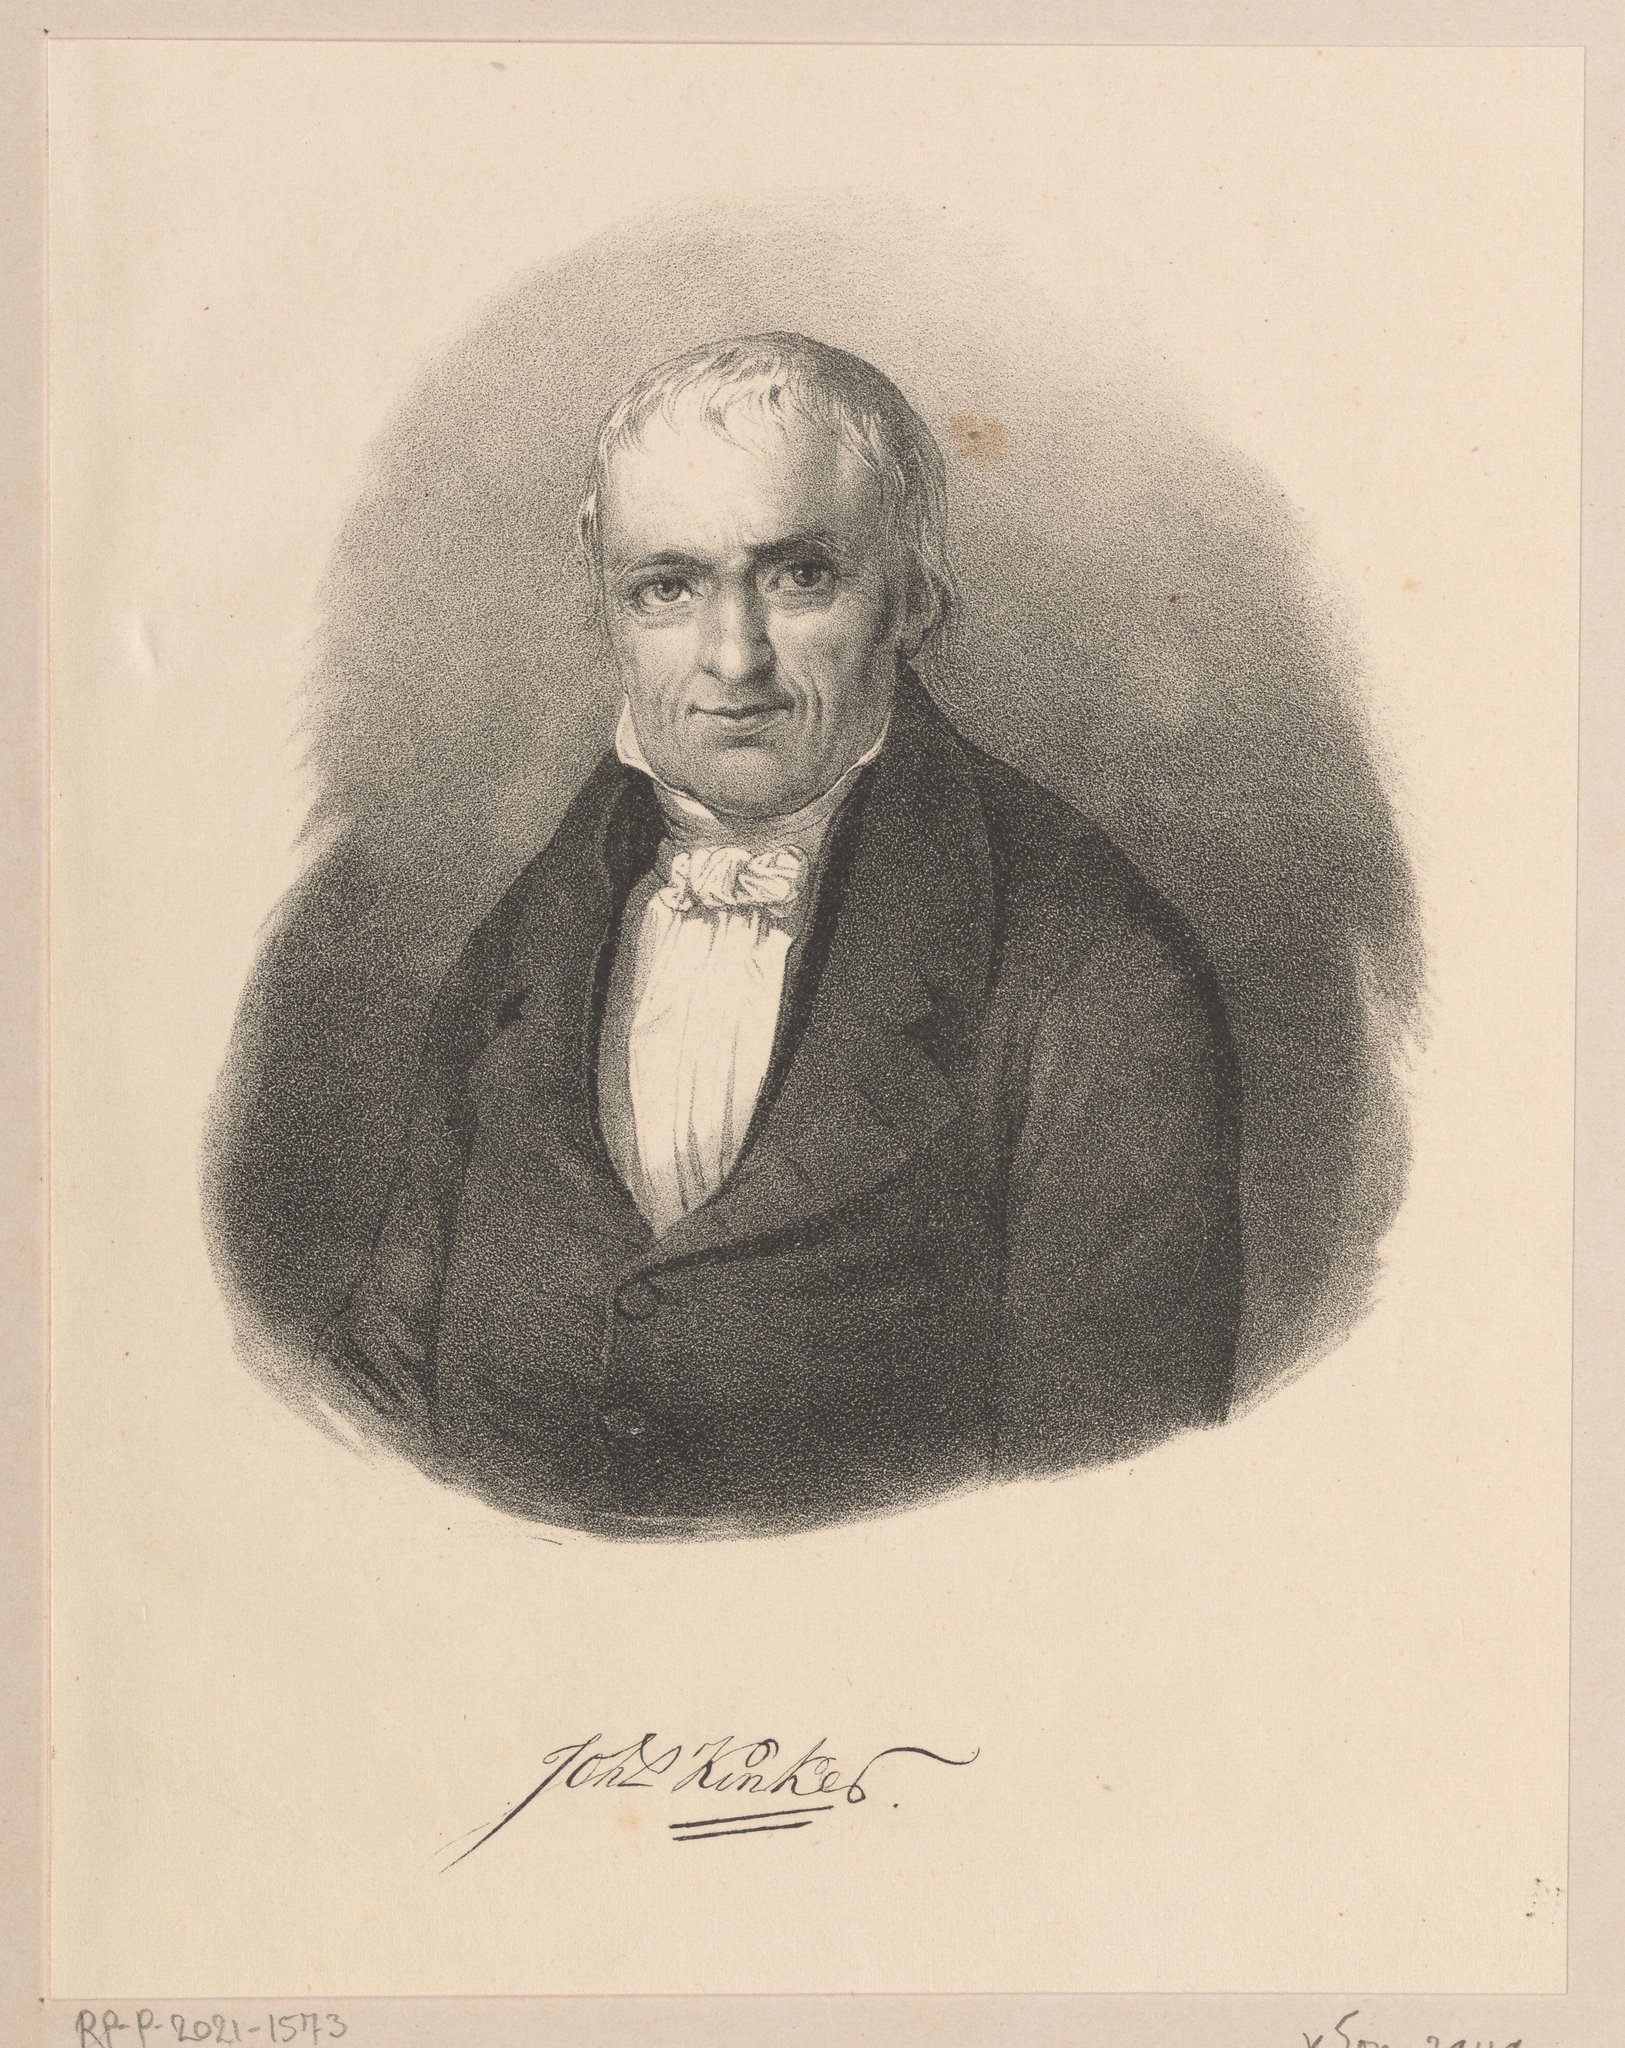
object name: print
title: Portret van Johannes Kinker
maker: Anonymous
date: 1794-1899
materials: paper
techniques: lithograph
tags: amsterdam, johannes kinker, historical persons, writer, poet, author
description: Onder het portret een facsimile van de handtekening van de geportretteerde.